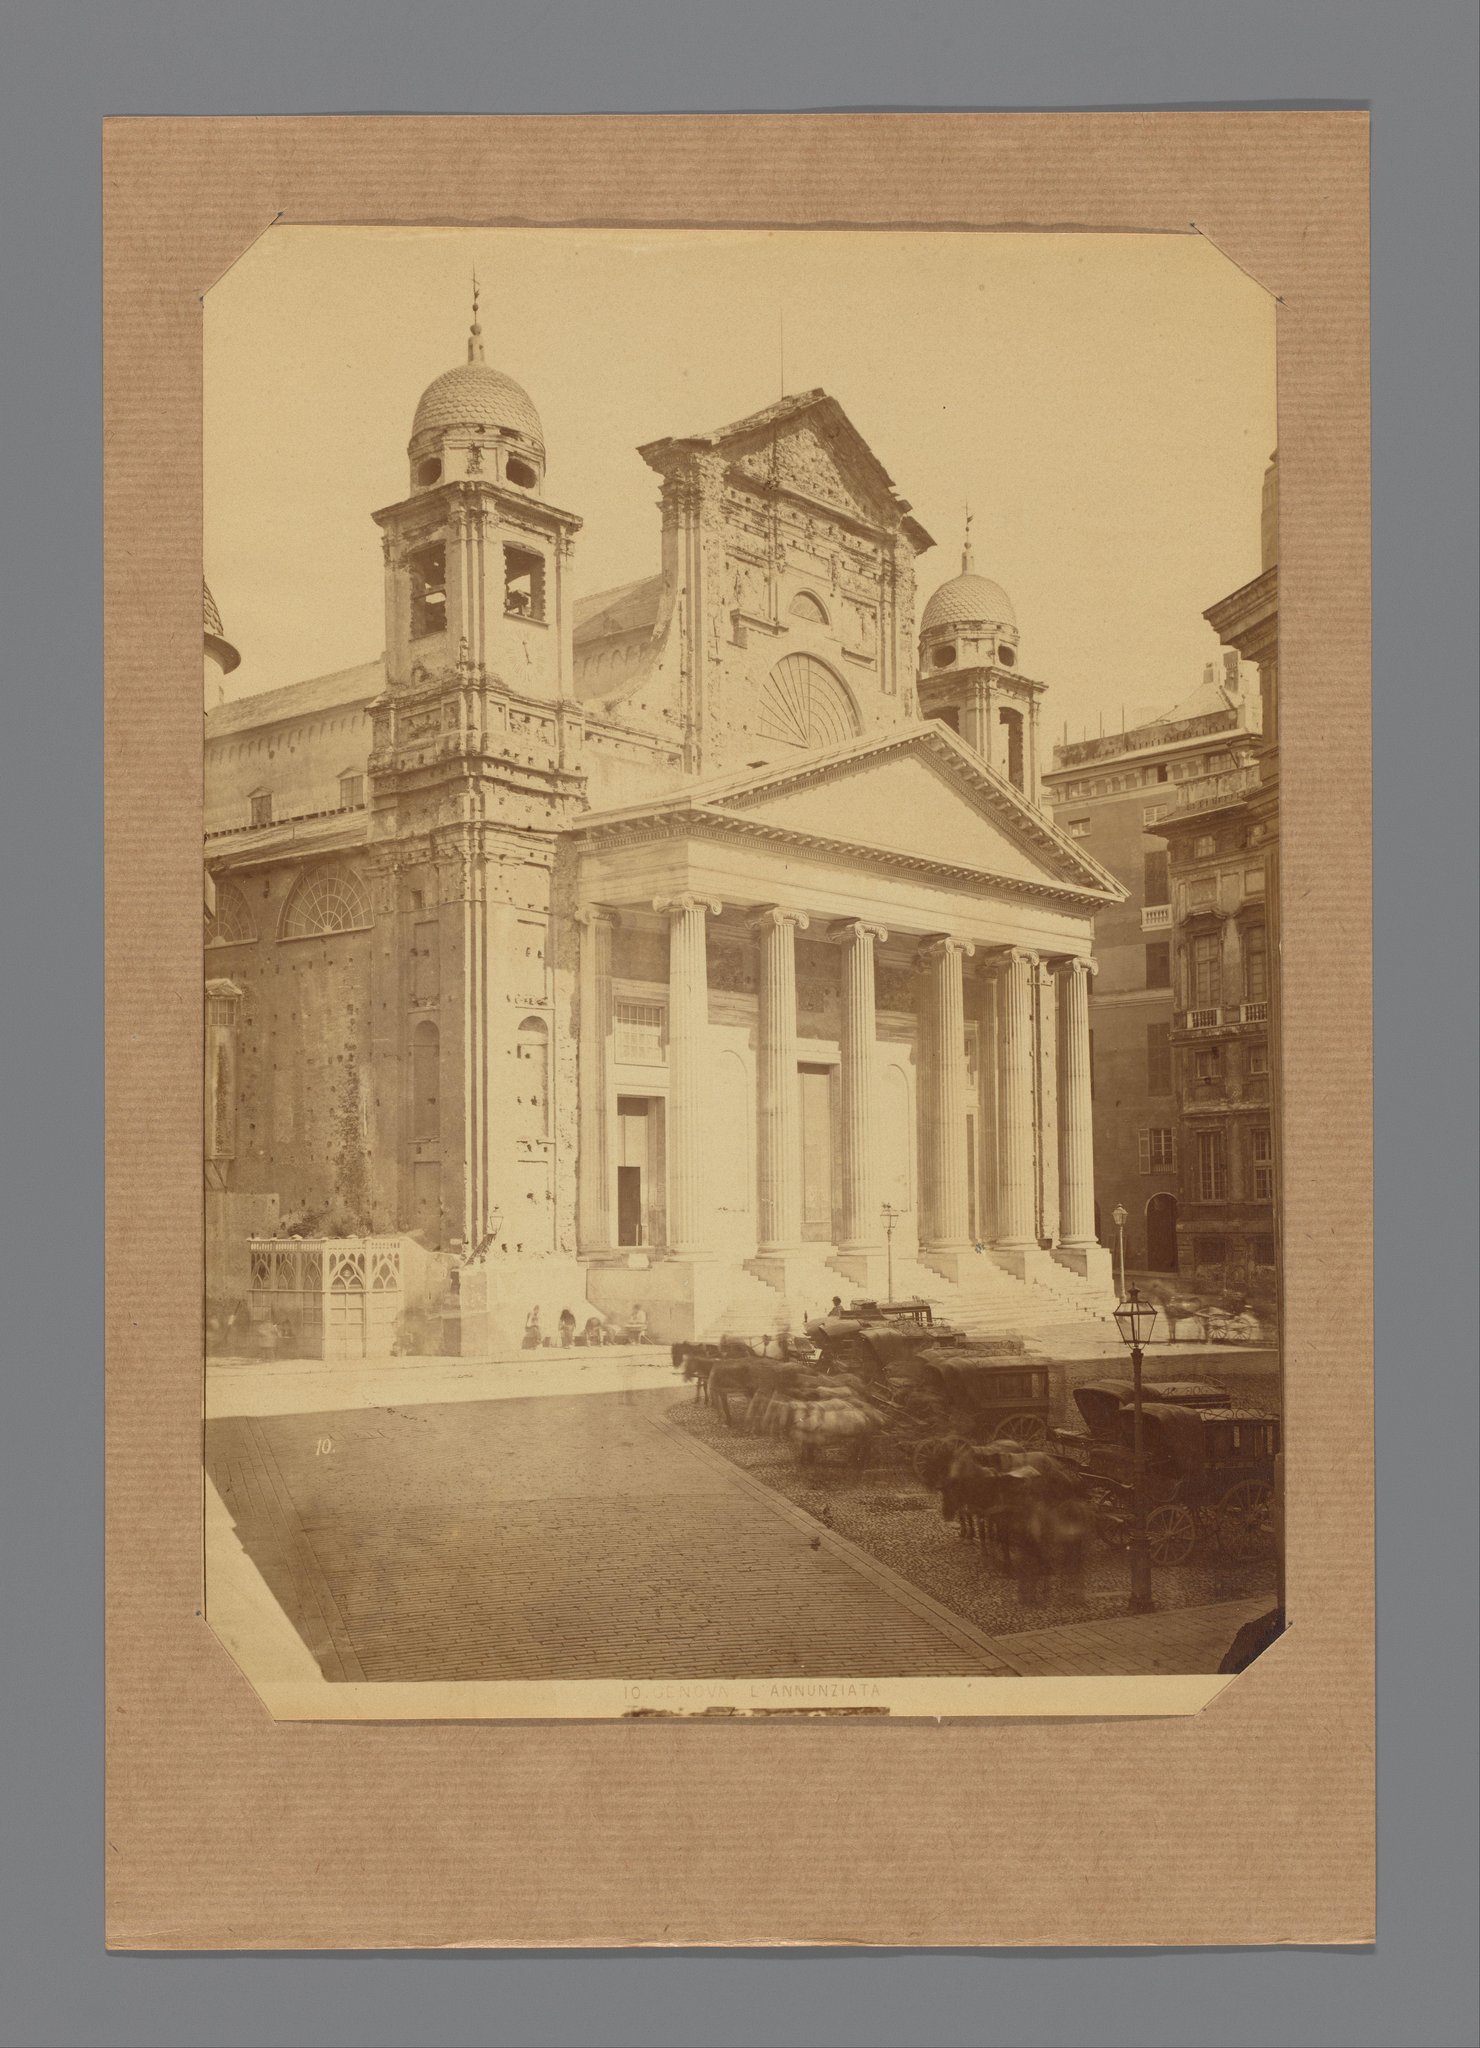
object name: photograph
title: Italië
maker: Anonymous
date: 1880-1910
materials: photographic support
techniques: albumen print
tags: italy